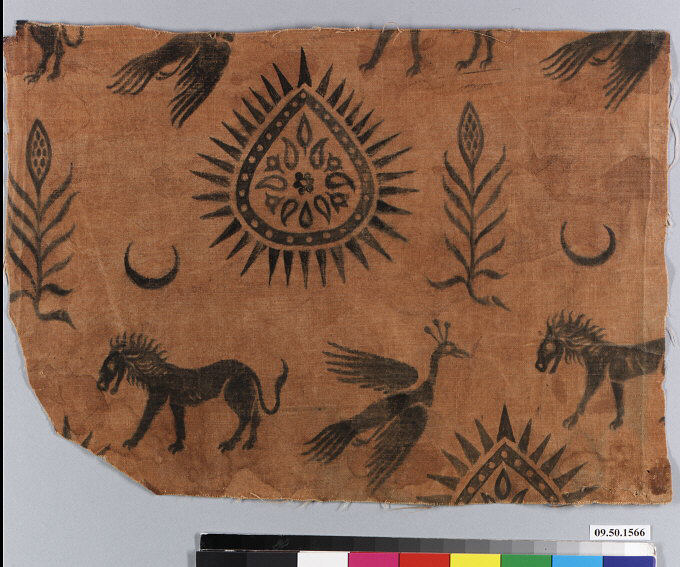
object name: fragment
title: Fragment reproducing 12th century design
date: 1801-1900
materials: cotton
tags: animals,birds,plants